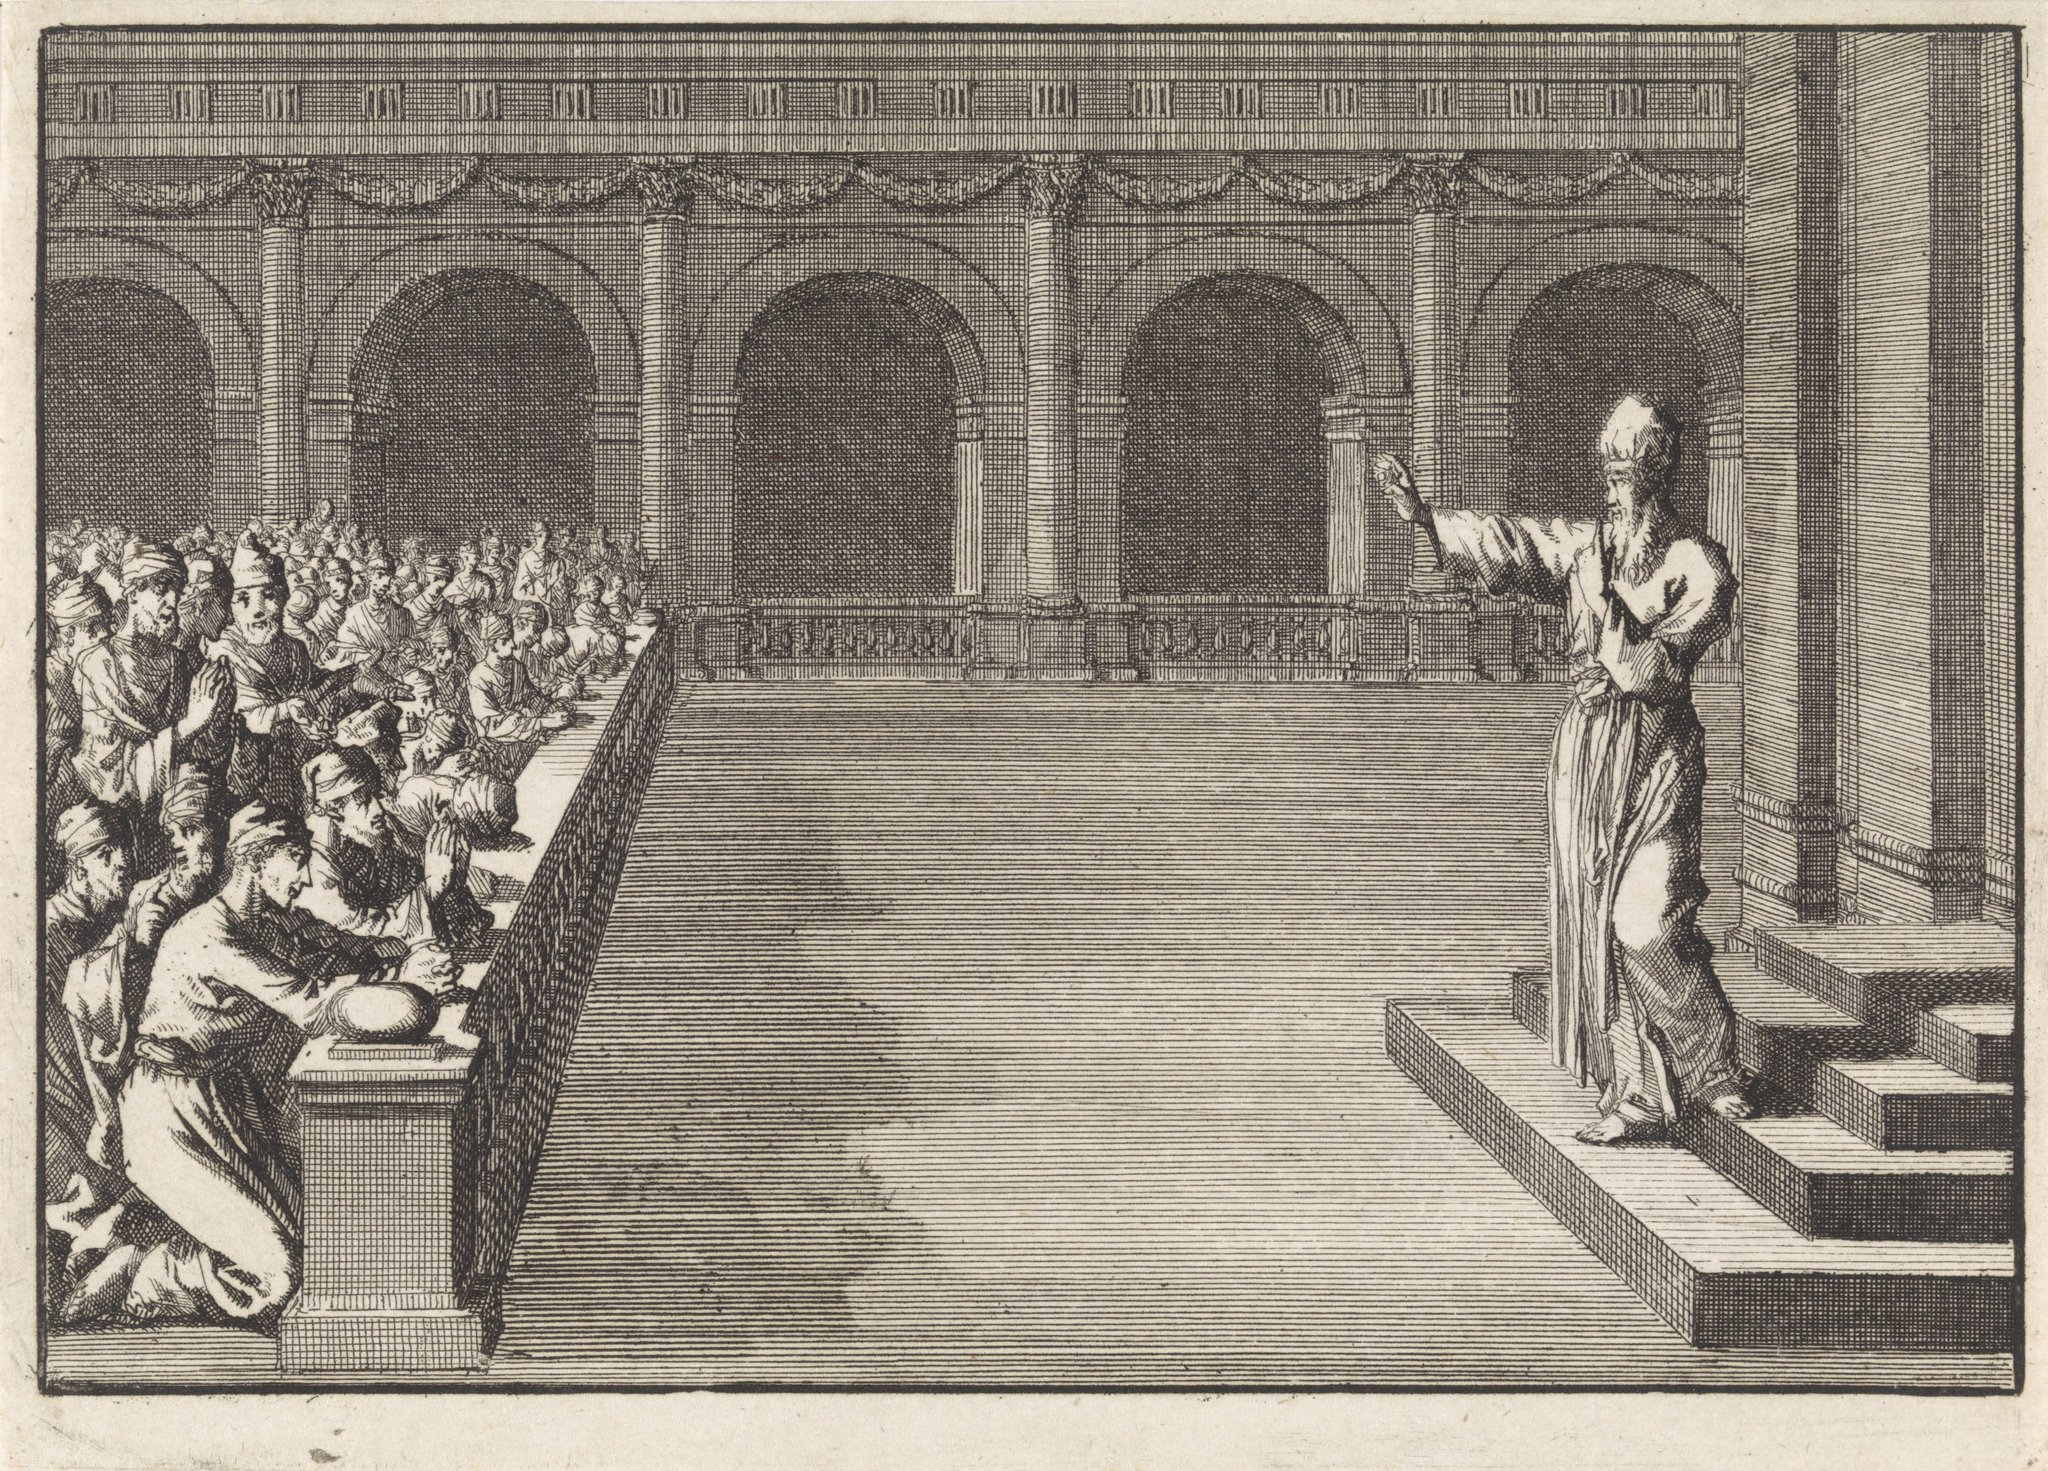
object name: print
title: Zacharias tracht de menigte toe te spreken maar blijft stom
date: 1703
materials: paper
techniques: etching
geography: haarlem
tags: zacharias speechless before the people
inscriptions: collector's mark: Lugt 2228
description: Proefdruk van een boekillustratie voor David Martin. Historie des Ouden en Nieuwen Testaments. Amsterdam, Pieter Mortier, 1703. Deel II. De boekillustraties voor de Mortierbijbel hebben verschillende staten en kopieën, waarbij de chronologische volgorde moeilijk te achterhalen valt. Als boekillustraties werden ze bovendien herhaaldelijk opnieuw gebruikt voor andere boekwerken.